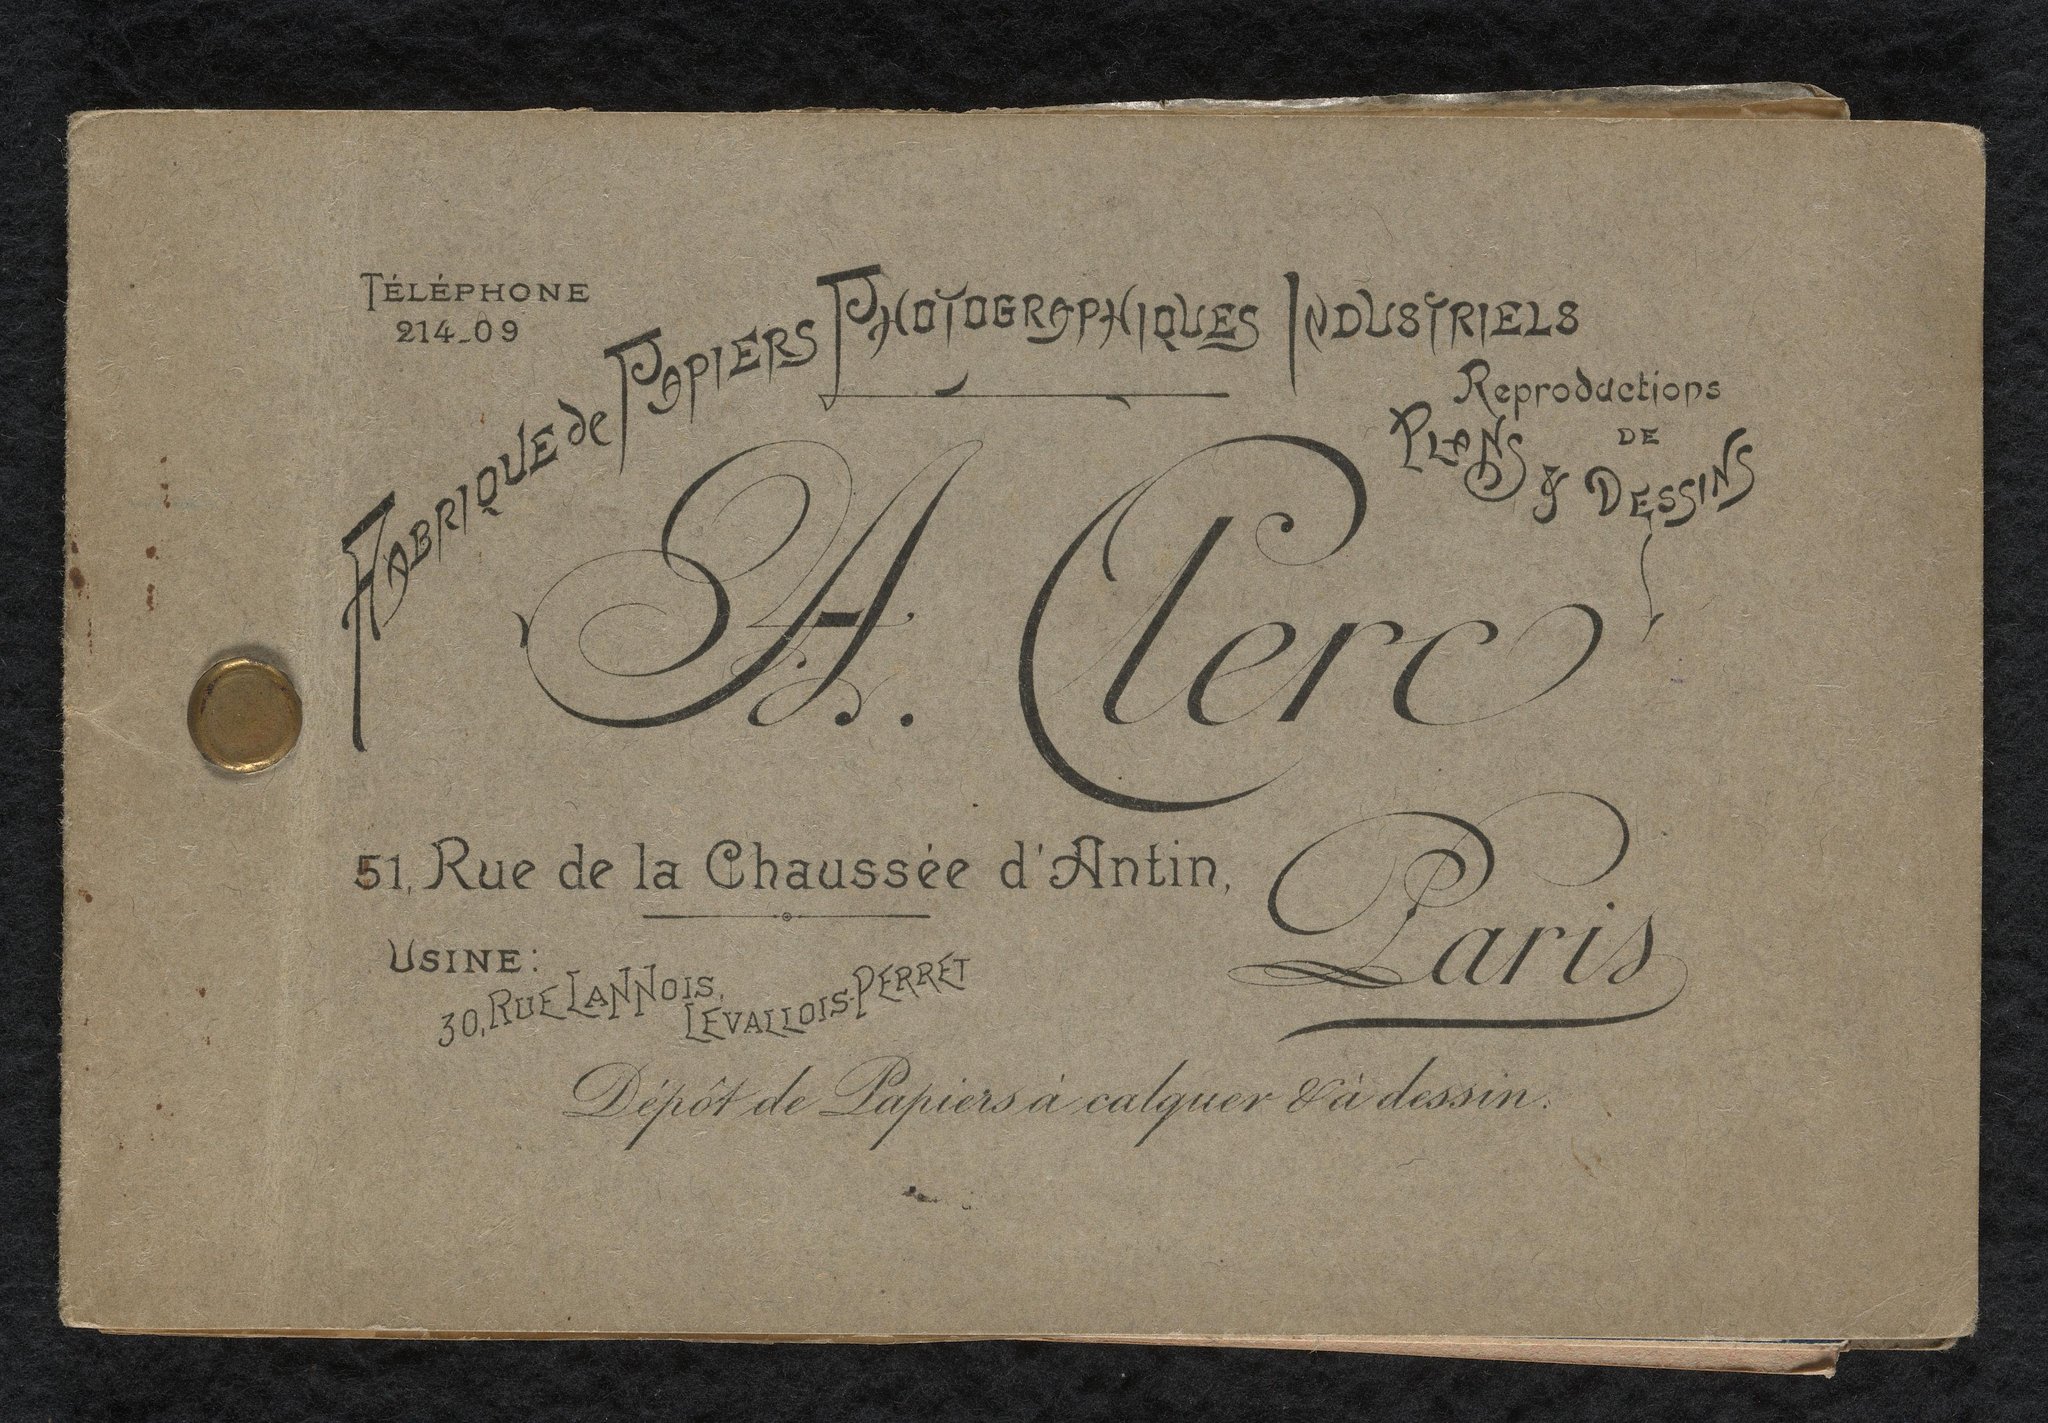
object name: book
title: Fabrique de Papiers Photographiques Industriels A. Clerc (...)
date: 1910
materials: paper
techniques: cyanotype, iron processes, letterpress printing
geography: paris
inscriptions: date: ‘APR 2010’